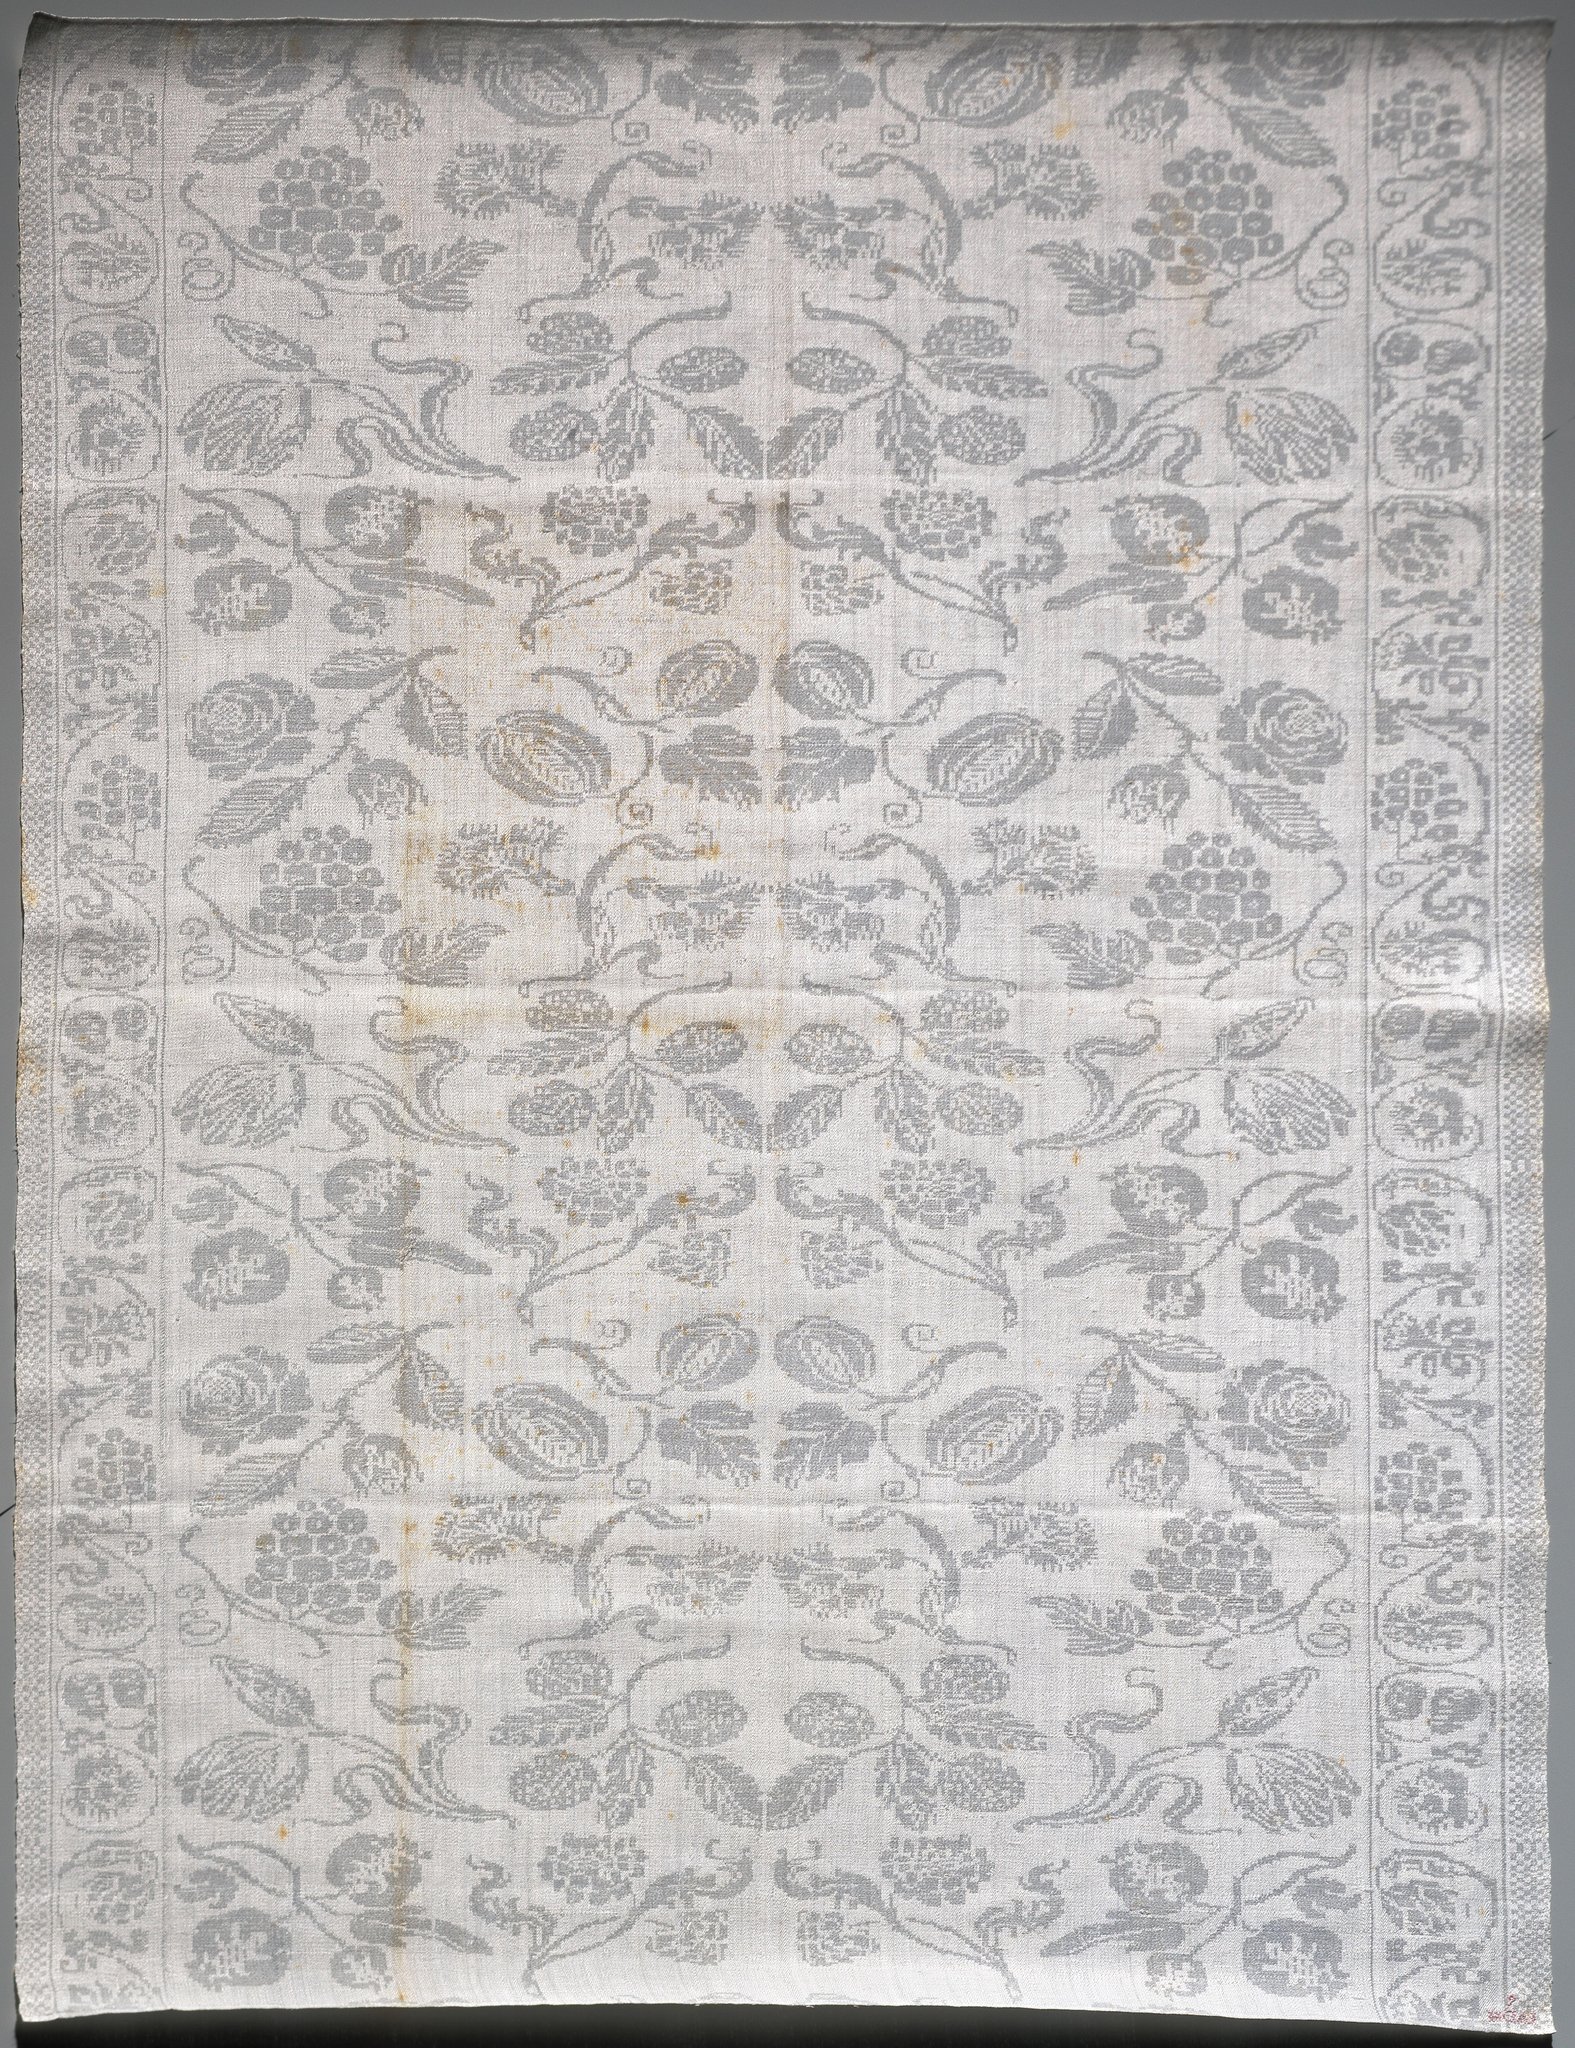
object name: napkin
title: Servet met bloemen en vruchten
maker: Anonymous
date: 1650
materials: linen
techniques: damask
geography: northern netherlands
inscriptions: mark: ‘IVDH 6’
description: Servet van linnendamast met patroon van "gesaaide blom" en vruchten. Een laag symmetrisch patroon vertoont vrij grote bloemen en vruchten aan een gezwenkt takje. Onder andere herkenbaar zijn roos, granaatappel, tulp, druiventros en meloen. Staande randen: enkelvoudige spiraalrank met narcis, druiventros en bloemen.